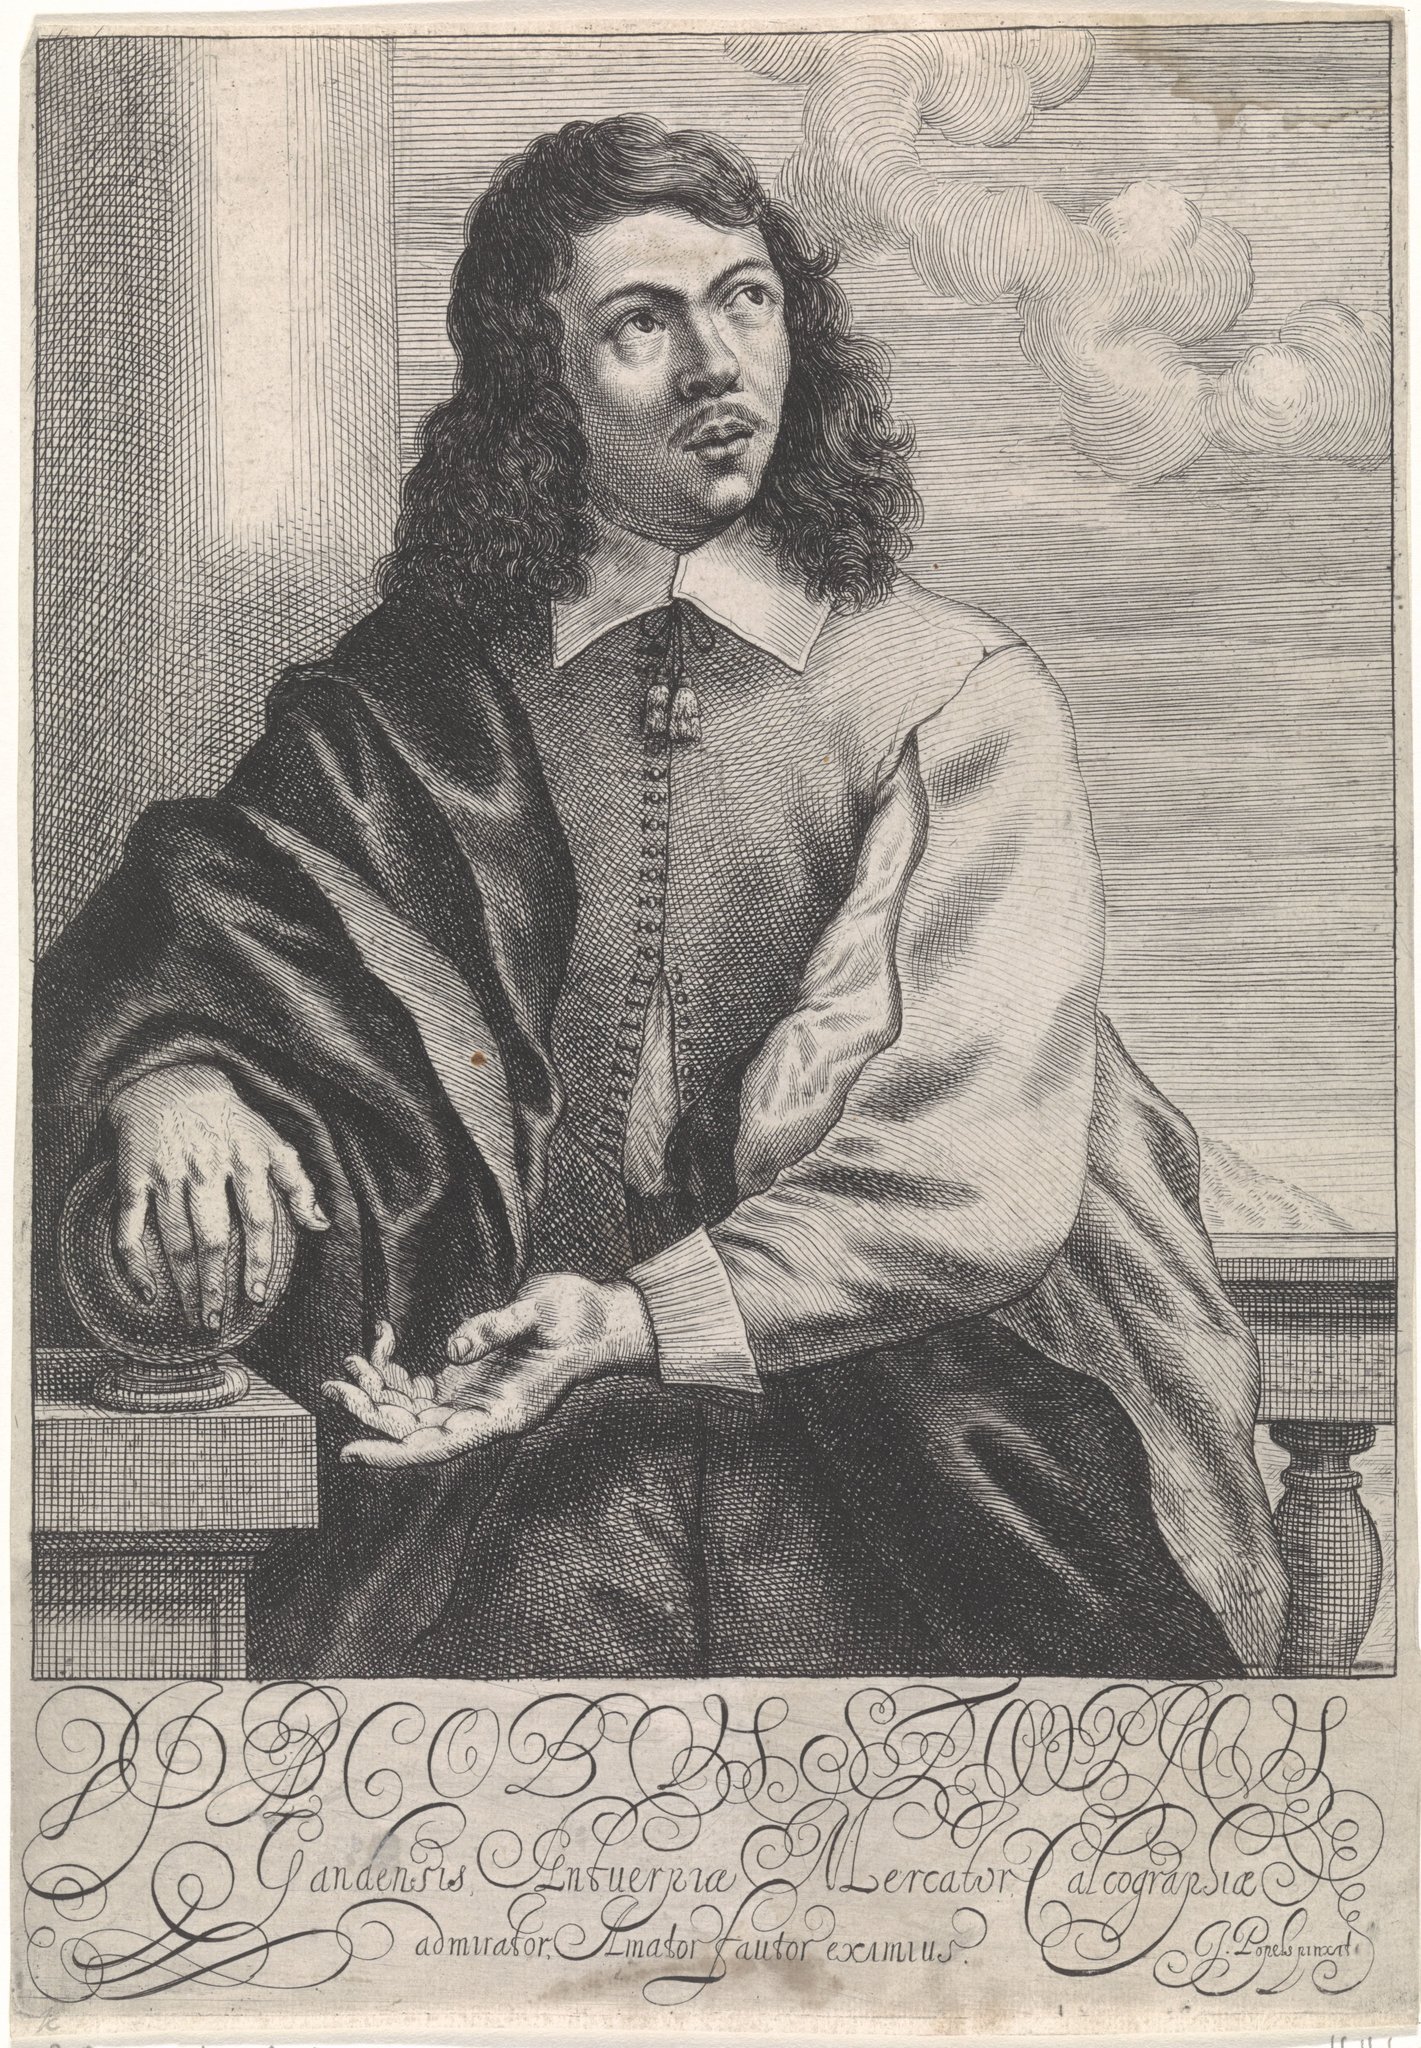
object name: print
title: Portret van Jacob Stoopius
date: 1630-1660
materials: paper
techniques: engraving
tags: portrait, self-portrait of painter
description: Portret ten halven lijve van de Antwerpse koopman en kalligraaf Jacob Stoopius, staand op een balustrade. Onder de afbeelding een tweeregelige Latijnse tekst.